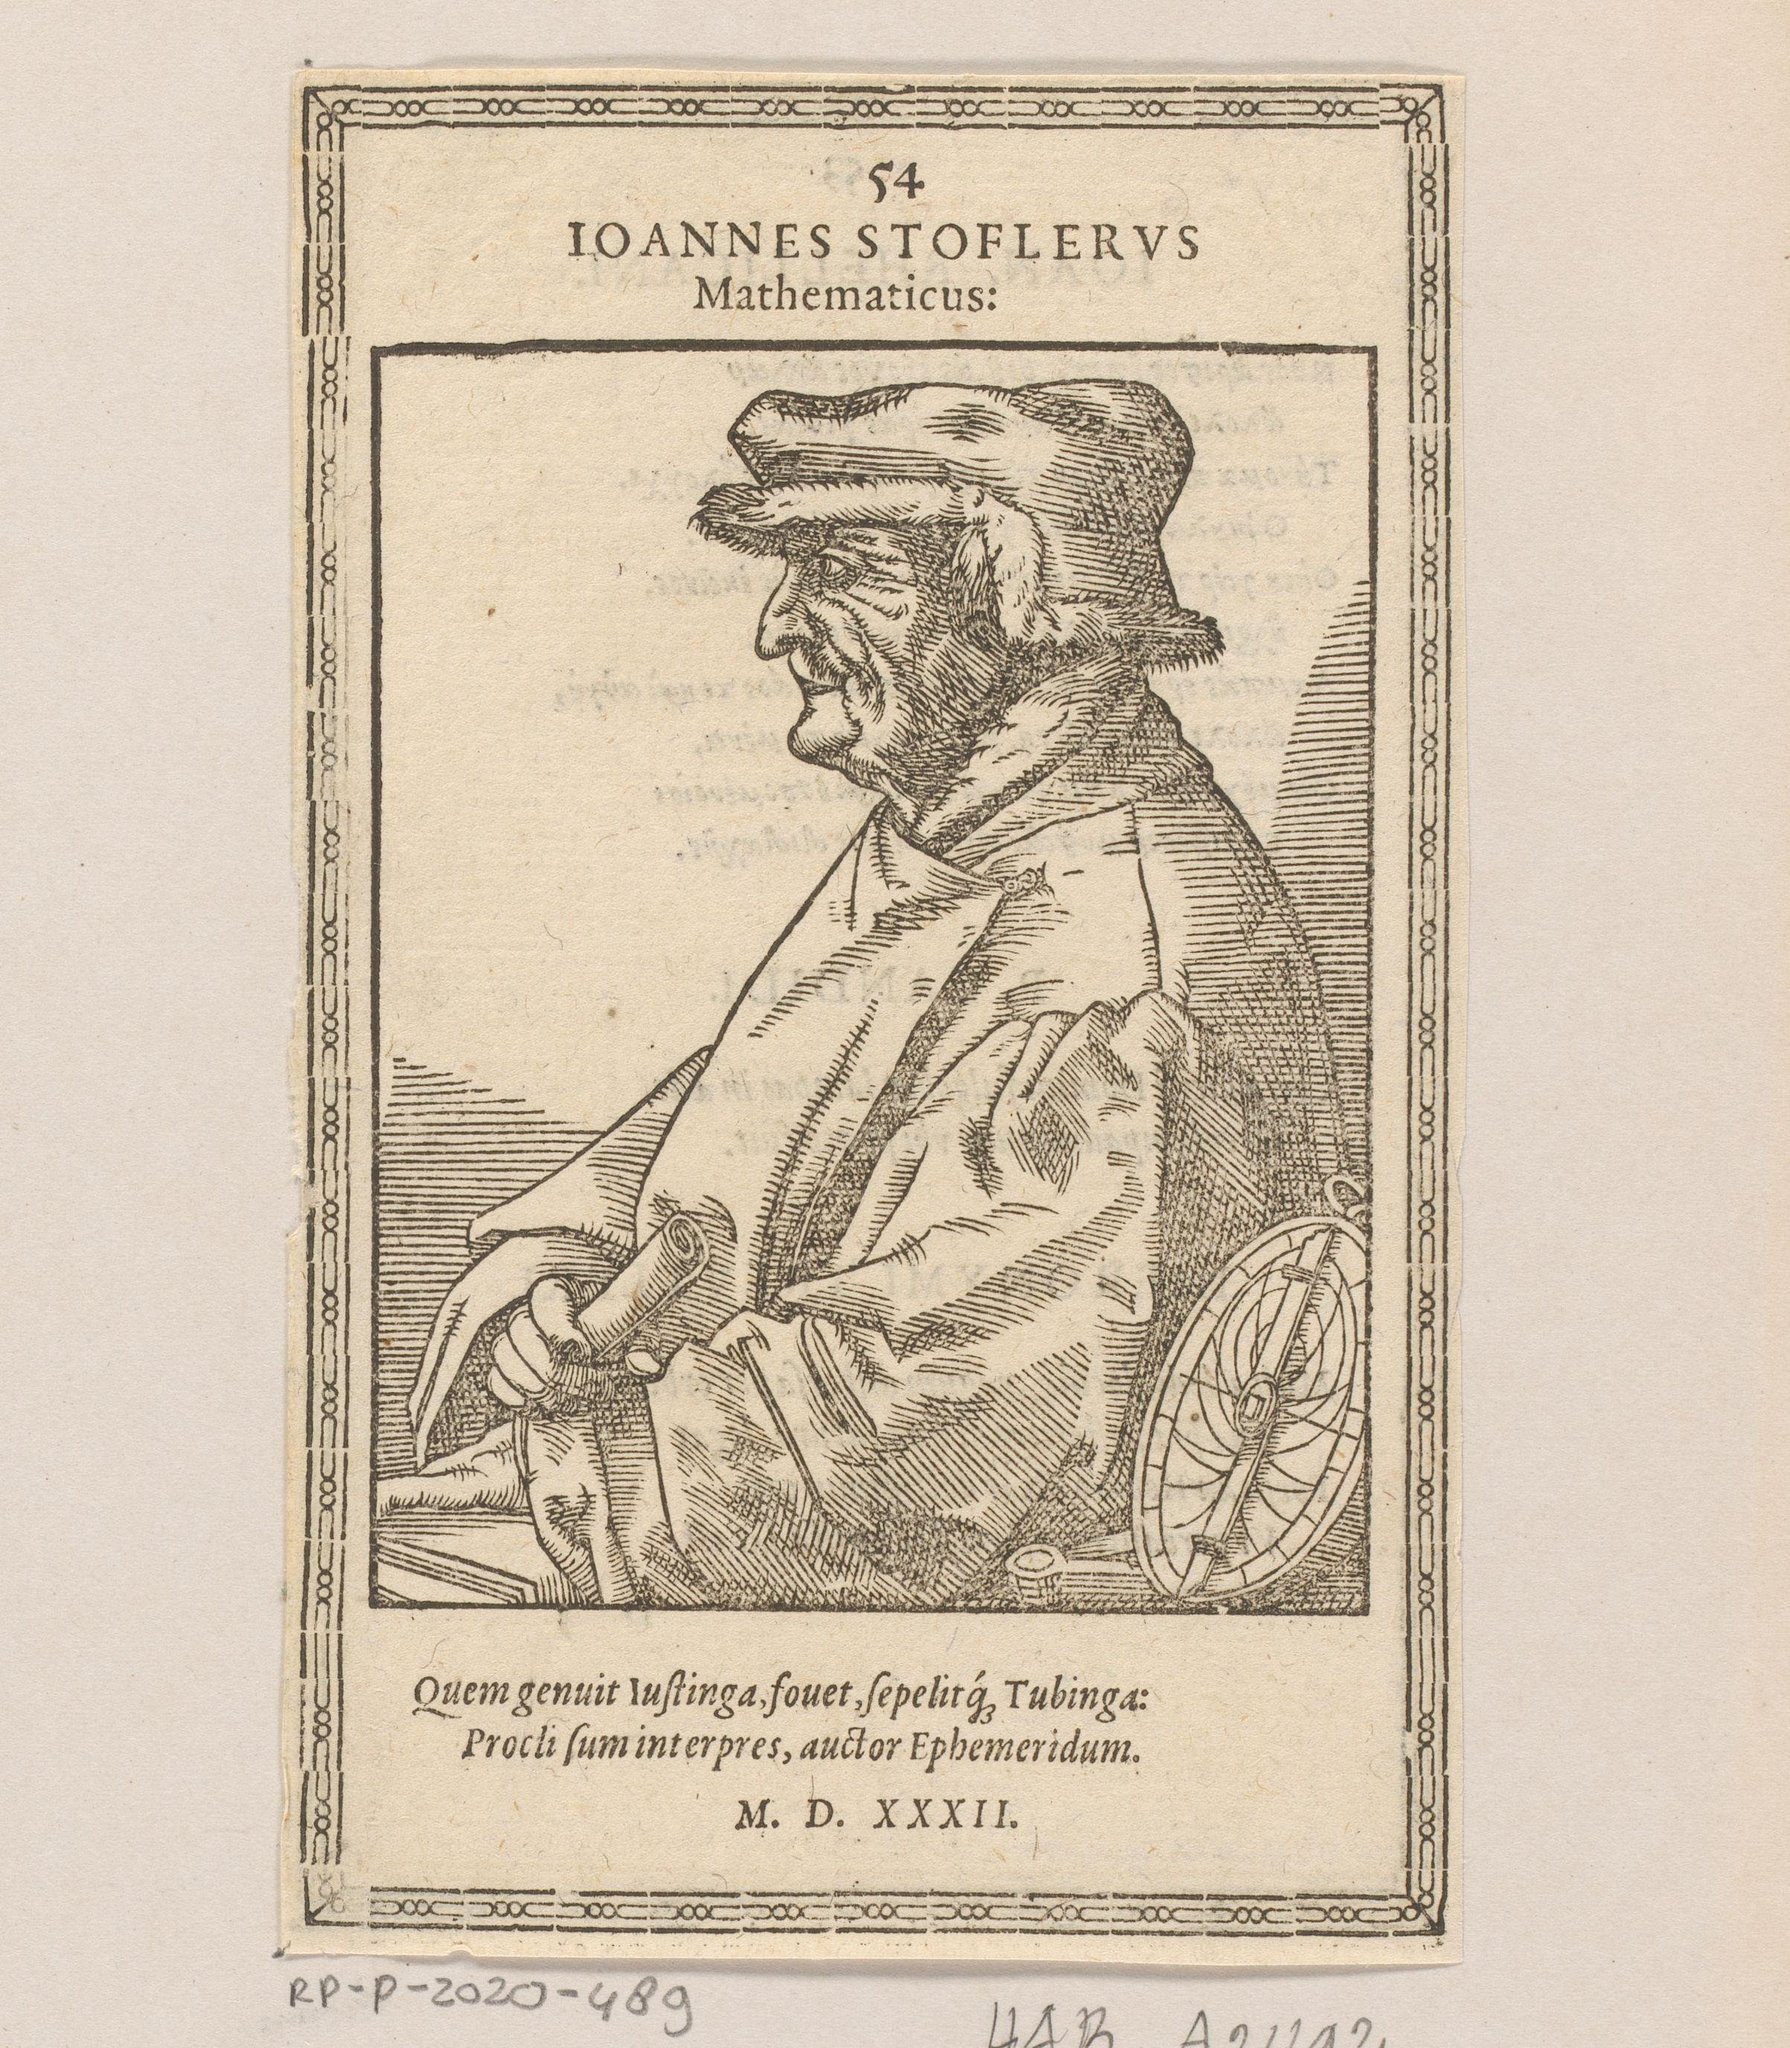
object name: print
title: Portret van Johannes Stöffler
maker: bernhard jobin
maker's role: printer, publisher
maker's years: 1545-1593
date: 1590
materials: paper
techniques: letterpress printing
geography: straatsburg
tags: publisher, johannes stöffler, historical persons, mathematics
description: Prent uit: Reusner, Nikolaus. Icones sive imagines virorum literis illustrium (...). Straatsburg: Bernhard Jobin, 1590, p. 54. Prent voor het eerst verschenen in de eerste editie van 1587. Prent mogelijk ook gebruikt in latere publicaties.